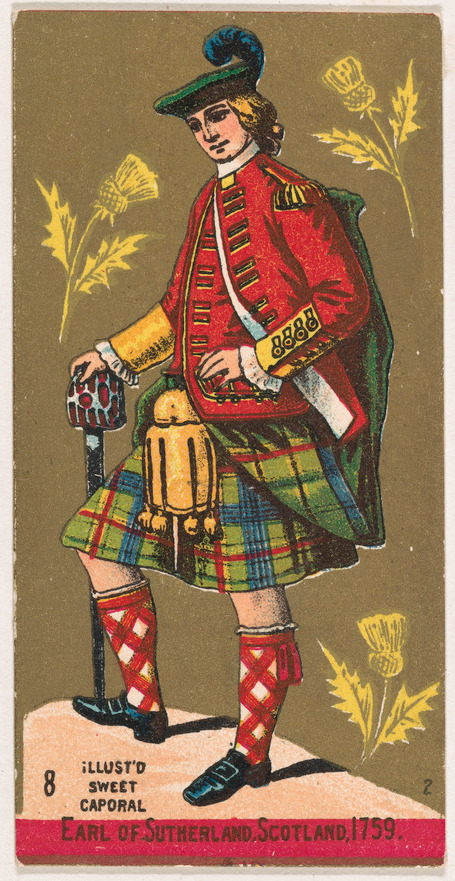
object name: print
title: Earl of Sutherland, Scotland, 1759, from the Military Series (N224) issued by Kinney Tobacco Company to promote Sweet Caporal Cigarettes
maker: kinney brothers tobacco company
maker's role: publisher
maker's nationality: american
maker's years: 1869-2011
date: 1888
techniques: color lithograph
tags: military,swords,men